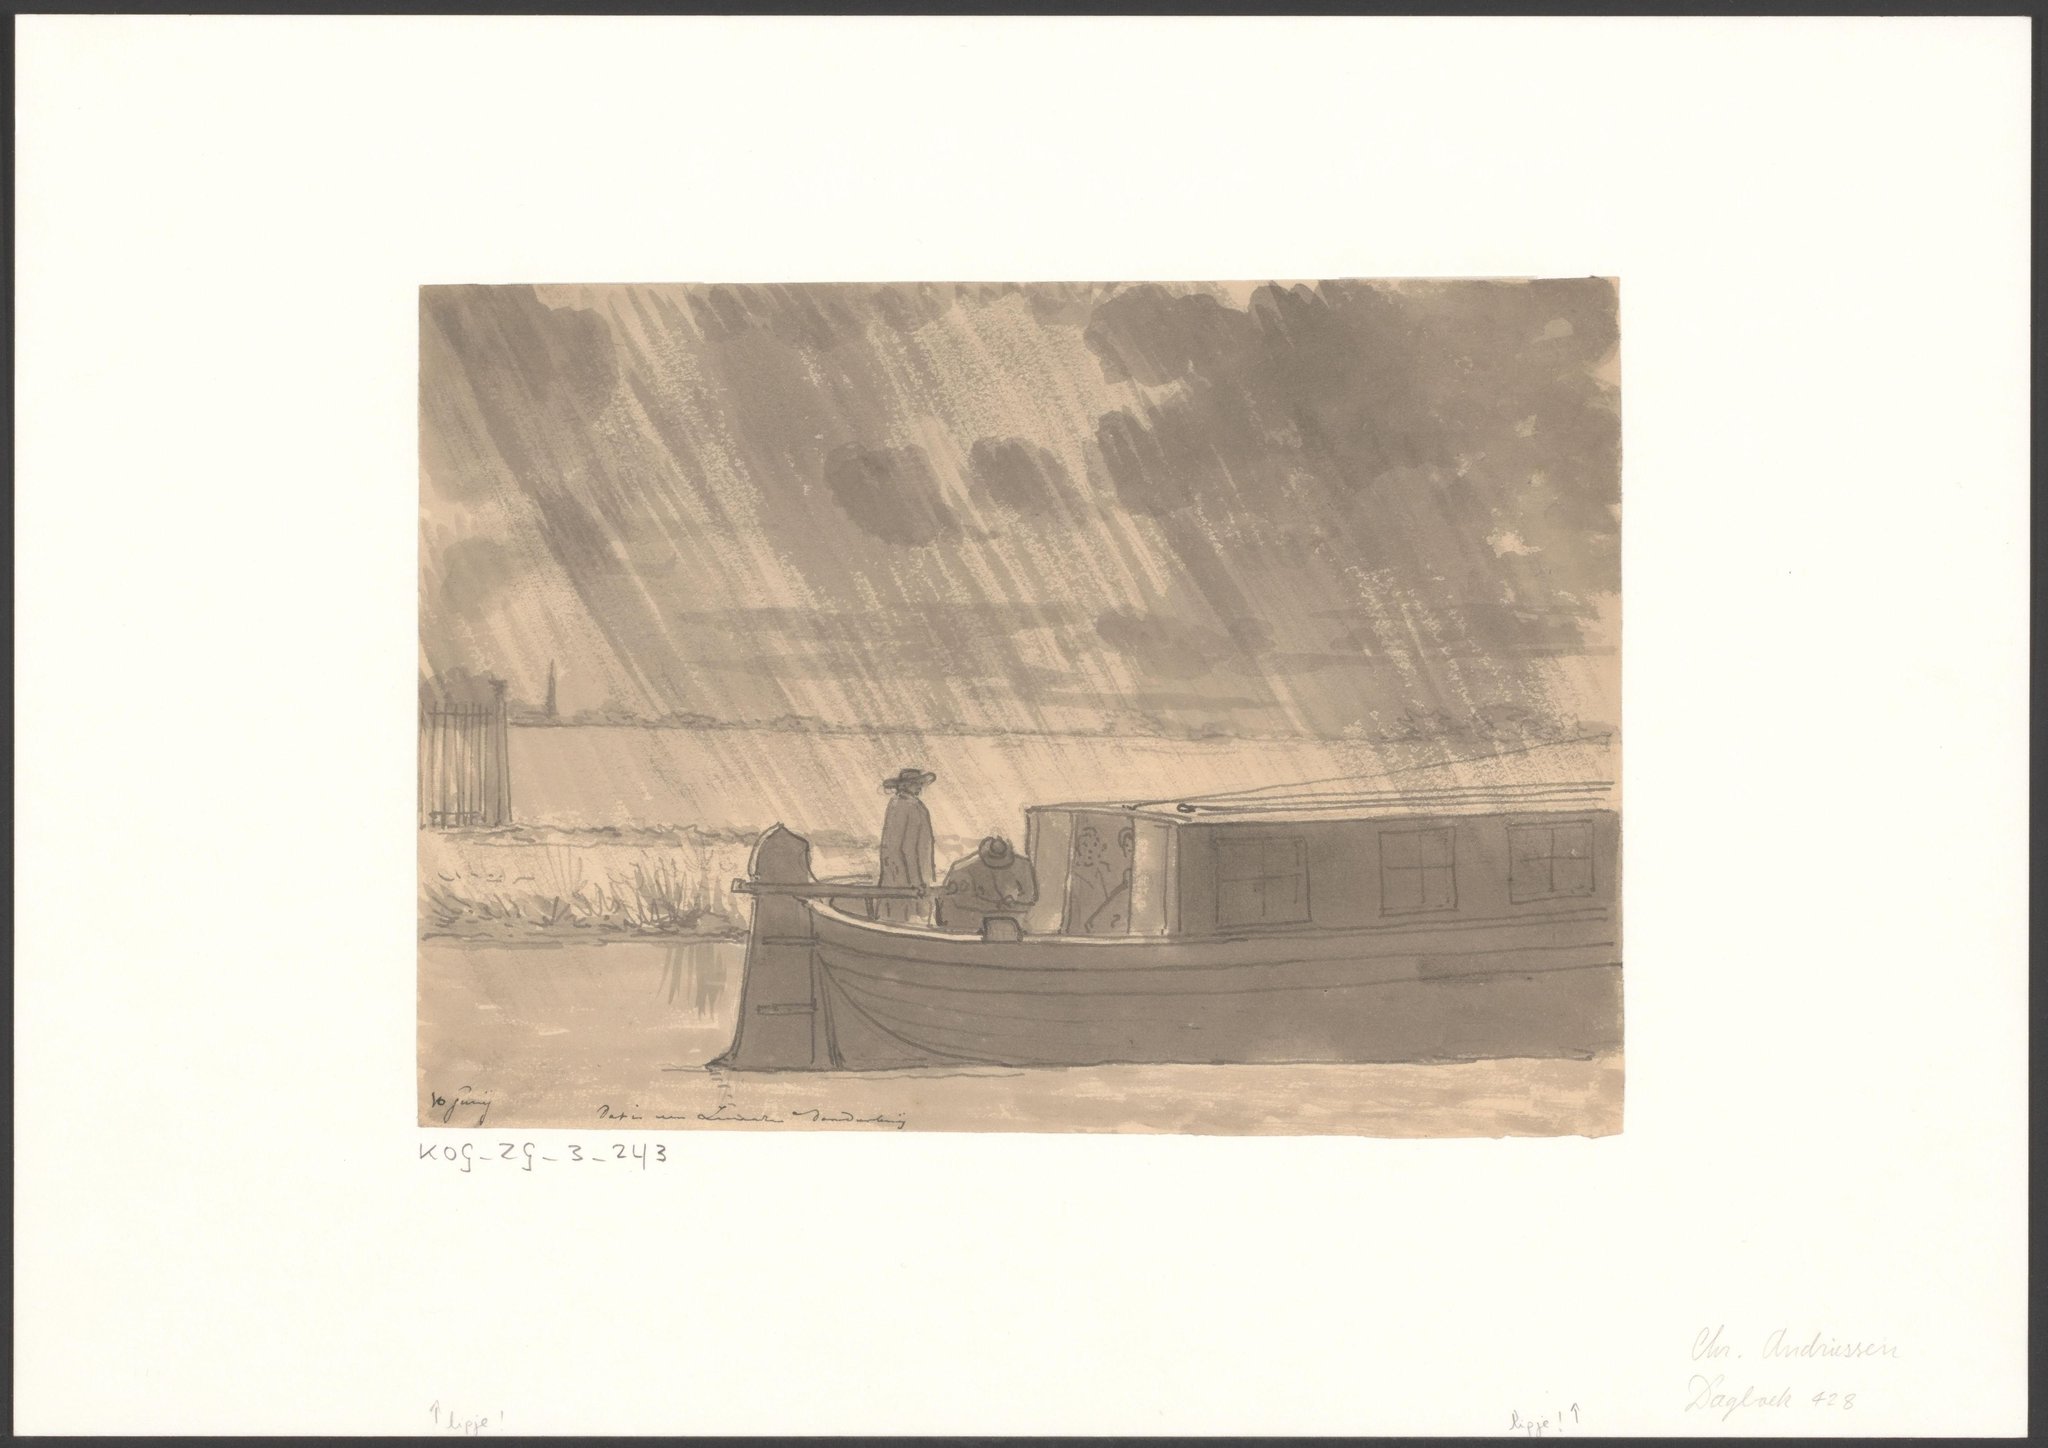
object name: drawing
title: Trekschuit uit Weesp tijdens een stortbui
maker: christiaan andriessen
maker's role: draughtsman, print maker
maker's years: 1775-1846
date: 1805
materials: ink, paper, pencil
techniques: brush, pen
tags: tow-boat, towing-barge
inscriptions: inscription: ‘10 junij dat is een zware donderbuij’, signature: ‘J Andriessen’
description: Dagboekblad uit het getekende dagboek dat Christiaan Andriessen bijhield van 1805 tot en met 1808.